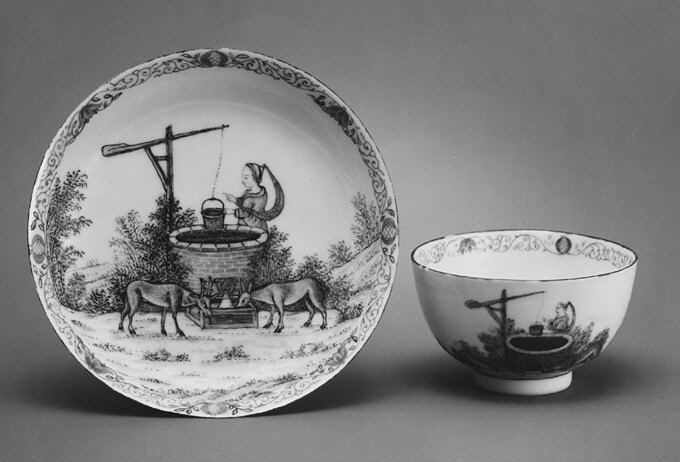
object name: teabowl and saucer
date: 1740-1750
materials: hard paste porcelain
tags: wells,women,deer